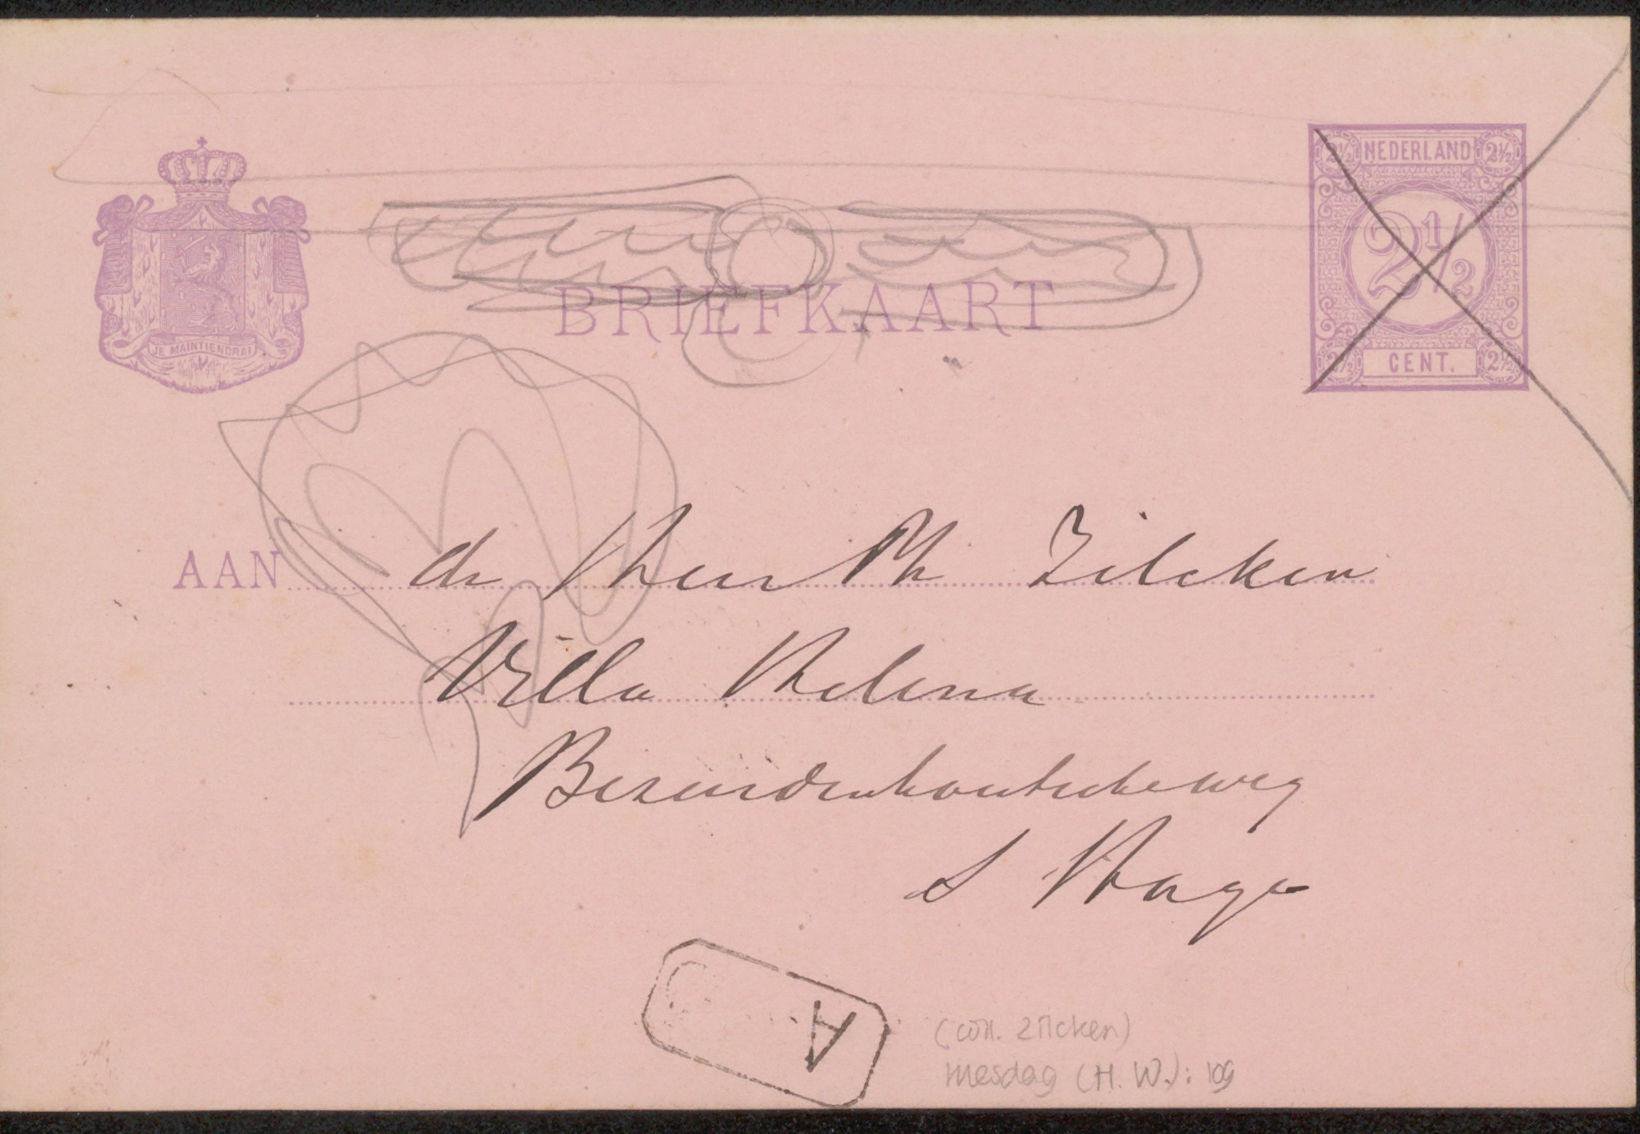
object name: postcard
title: Briefkaart aan Philip Zilcken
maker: hendrik willem mesdag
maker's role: draughtsman, painter, print maker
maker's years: 1831-1915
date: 1841-1915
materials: cardboard, ink, pencil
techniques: pen, writing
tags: philip zilcken, the arts of the stage: ballet, theatre, musical drama, motion picture